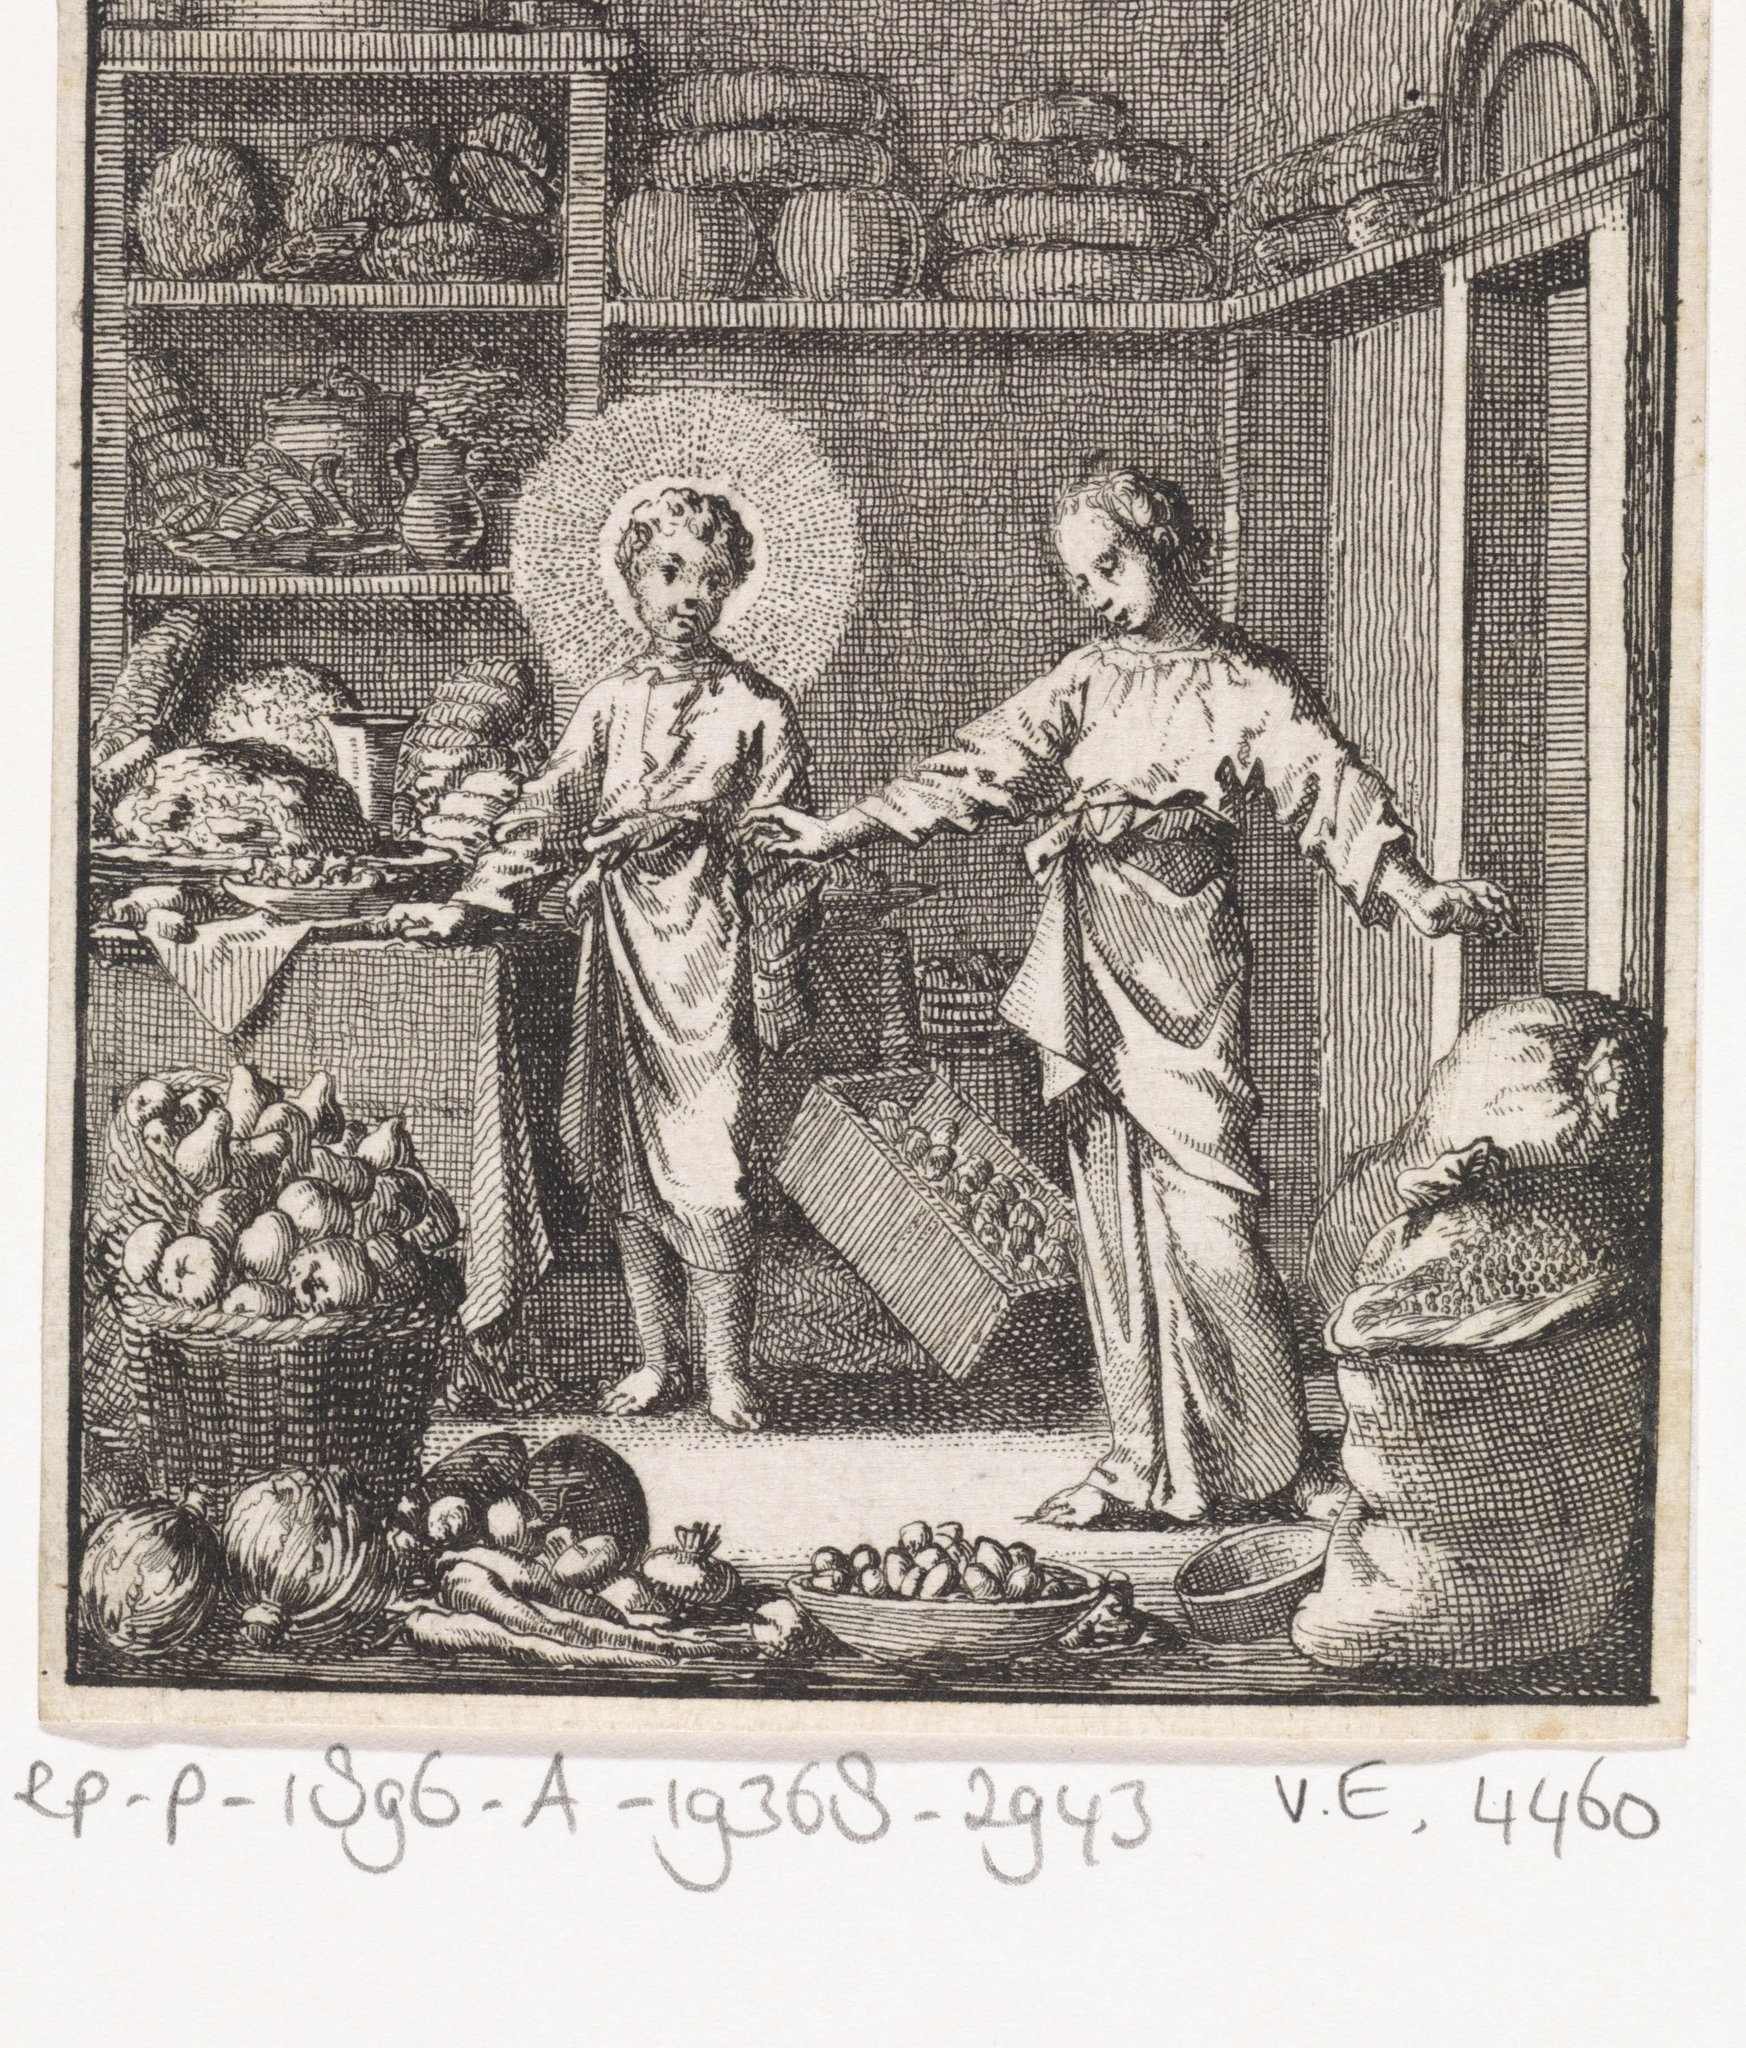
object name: print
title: Jezus en de Ziel in eene voorraadkamer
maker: jan luyken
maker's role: draughtsman, print maker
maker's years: 1649-1712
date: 1714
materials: paper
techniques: etching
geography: amsterdam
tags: christ and the soul, basement, cellar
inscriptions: collector's mark: Lugt 2228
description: Proefdruk van illustratie uit: Luyken, Jan. Jezus en de Ziel, 3 delen. Amsterdam: Wed. Pieter Arentsz II en Cornelis van der Sys, 1714, dl. II, p. 89.